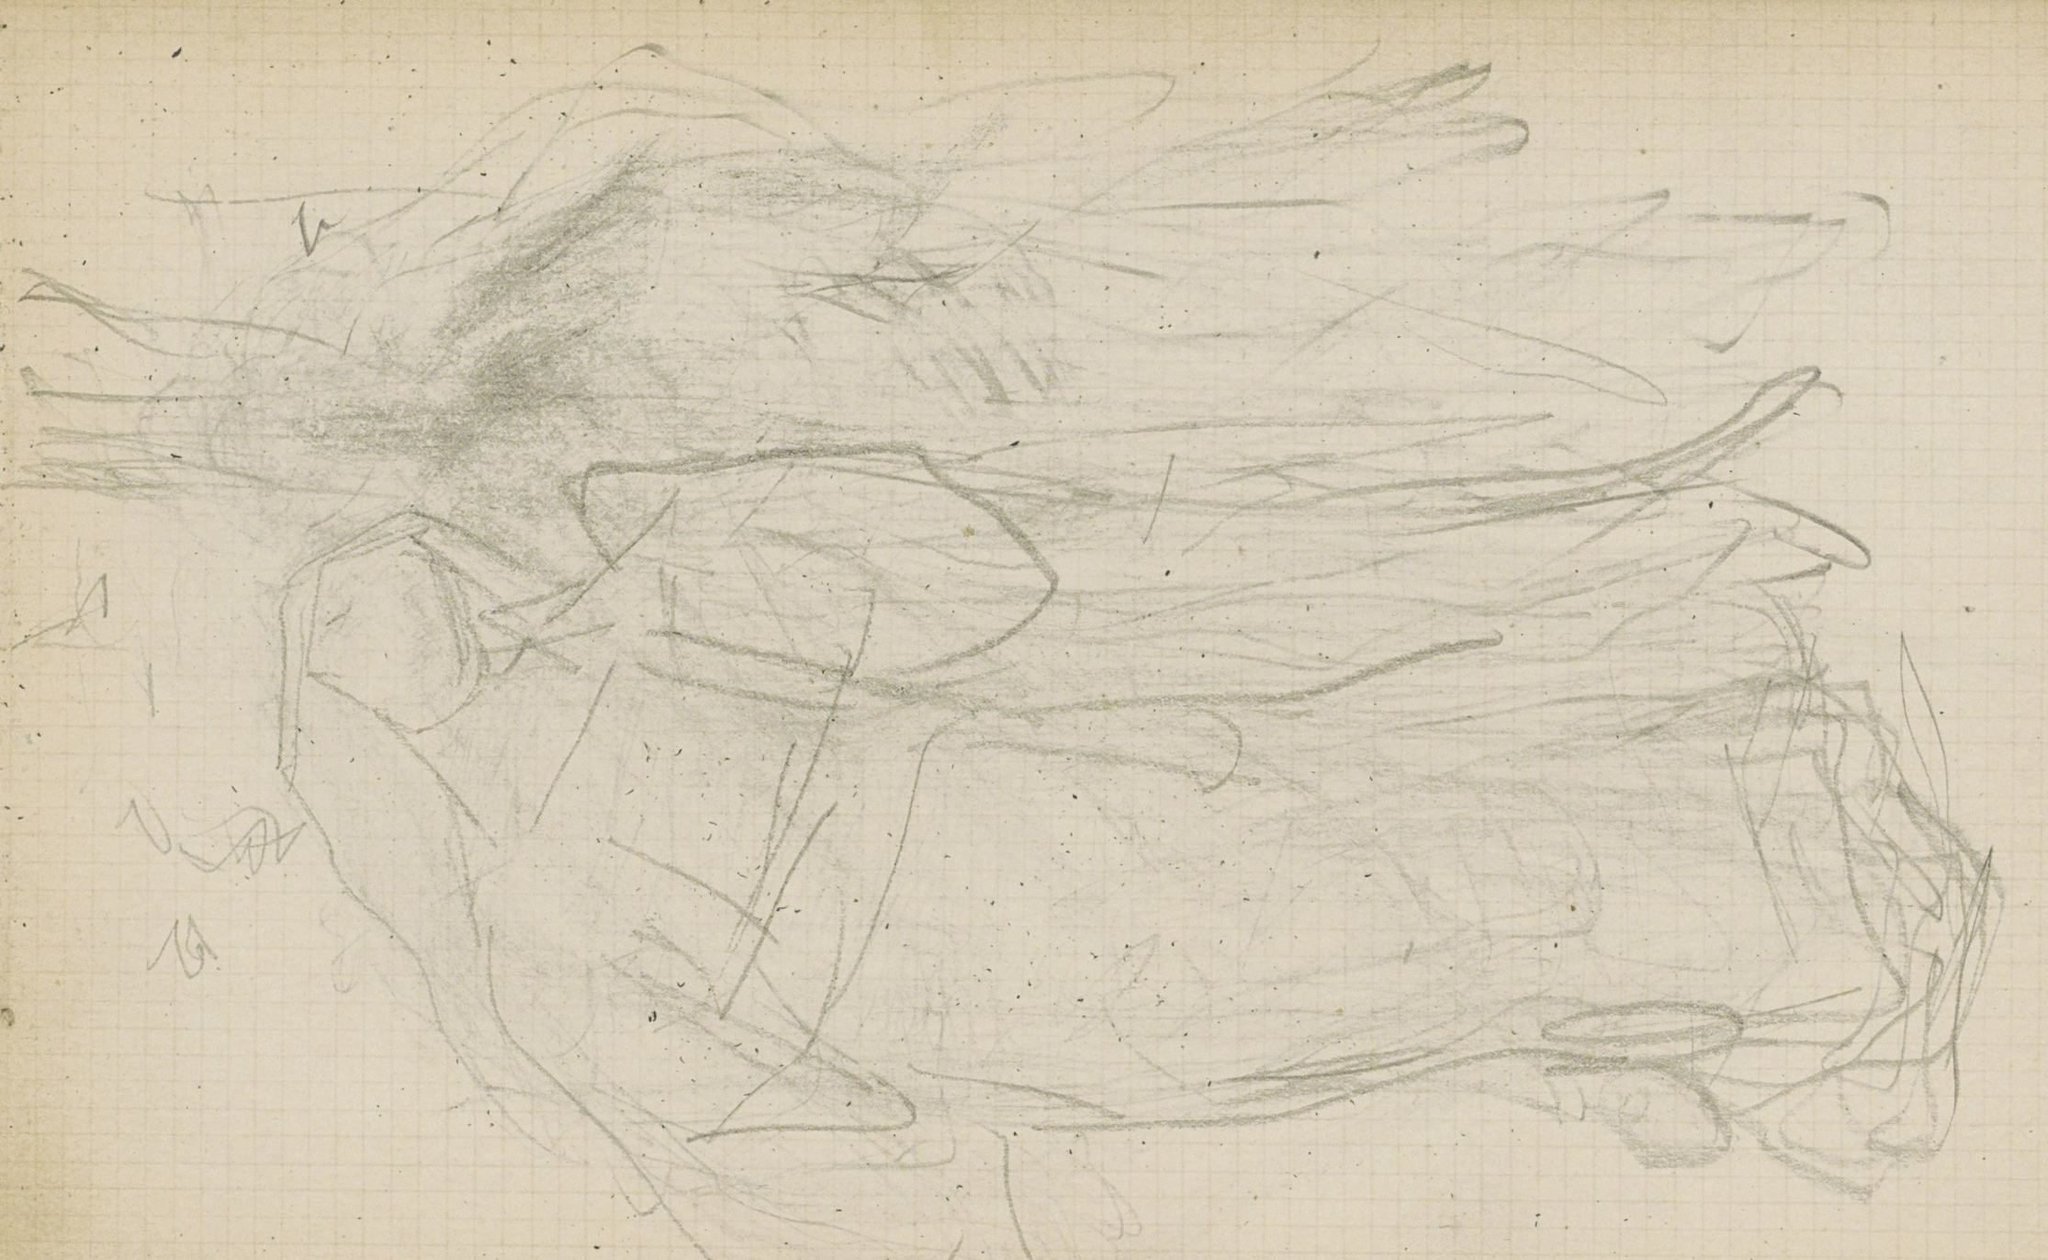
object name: sketchbook leaf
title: Staande vrouw in een lang gewaad, het hoofd naar rechts gebogen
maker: matthijs maris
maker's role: draughtsman, painter, print maker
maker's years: 1839-1917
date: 1849-1917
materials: pencil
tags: head slanting to the right, standing figure (+ female (human being) (not to be used where -aa- is prescribed))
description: Blad 22 recto uit een schetsboek met 35 bladen.